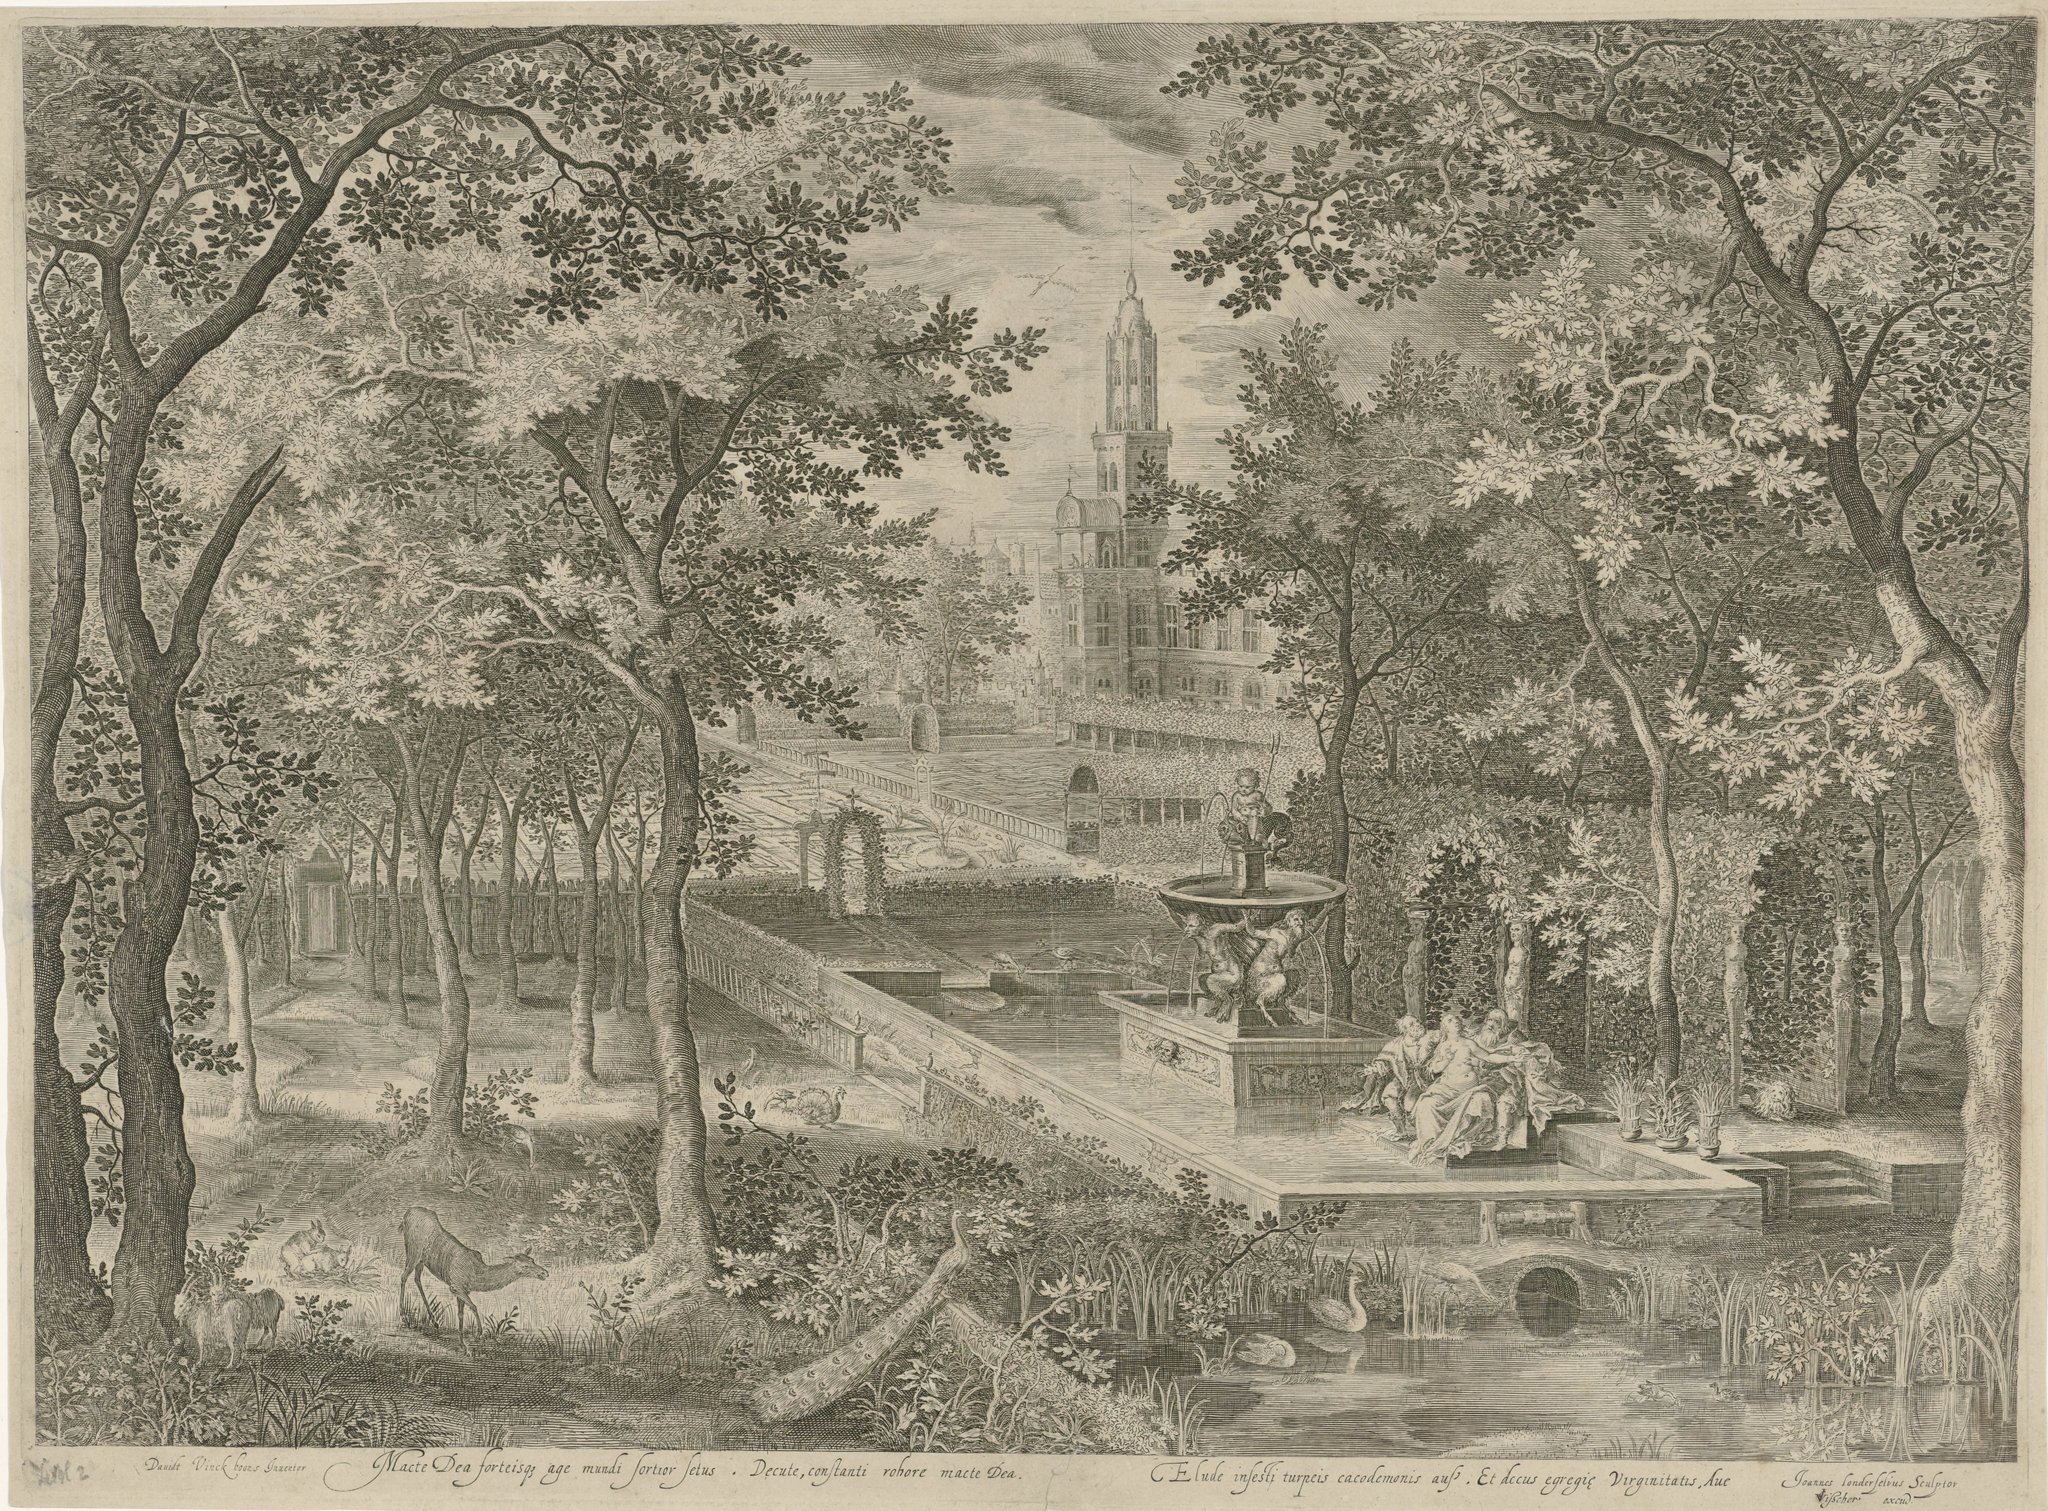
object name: print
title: Susanna en de ouderlingen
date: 1601-1652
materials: paper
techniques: engraving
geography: amsterdam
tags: castle, susanna bathing, usually in or near a fountain and sometimes accompanied by two female servants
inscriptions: collector's mark: Lugt 2228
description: In een rijk aangelegde kasteeltuin zit Susanna in een bassin bij een fontein. De twee ouderlingen zitten aan weerszijden van Susanna en proberen haar te verleiden. In de verte een kasteel, op de voorgrond een vijver en diverse dieren bij de bosrand. In de marge een onderschrift in Latijn.